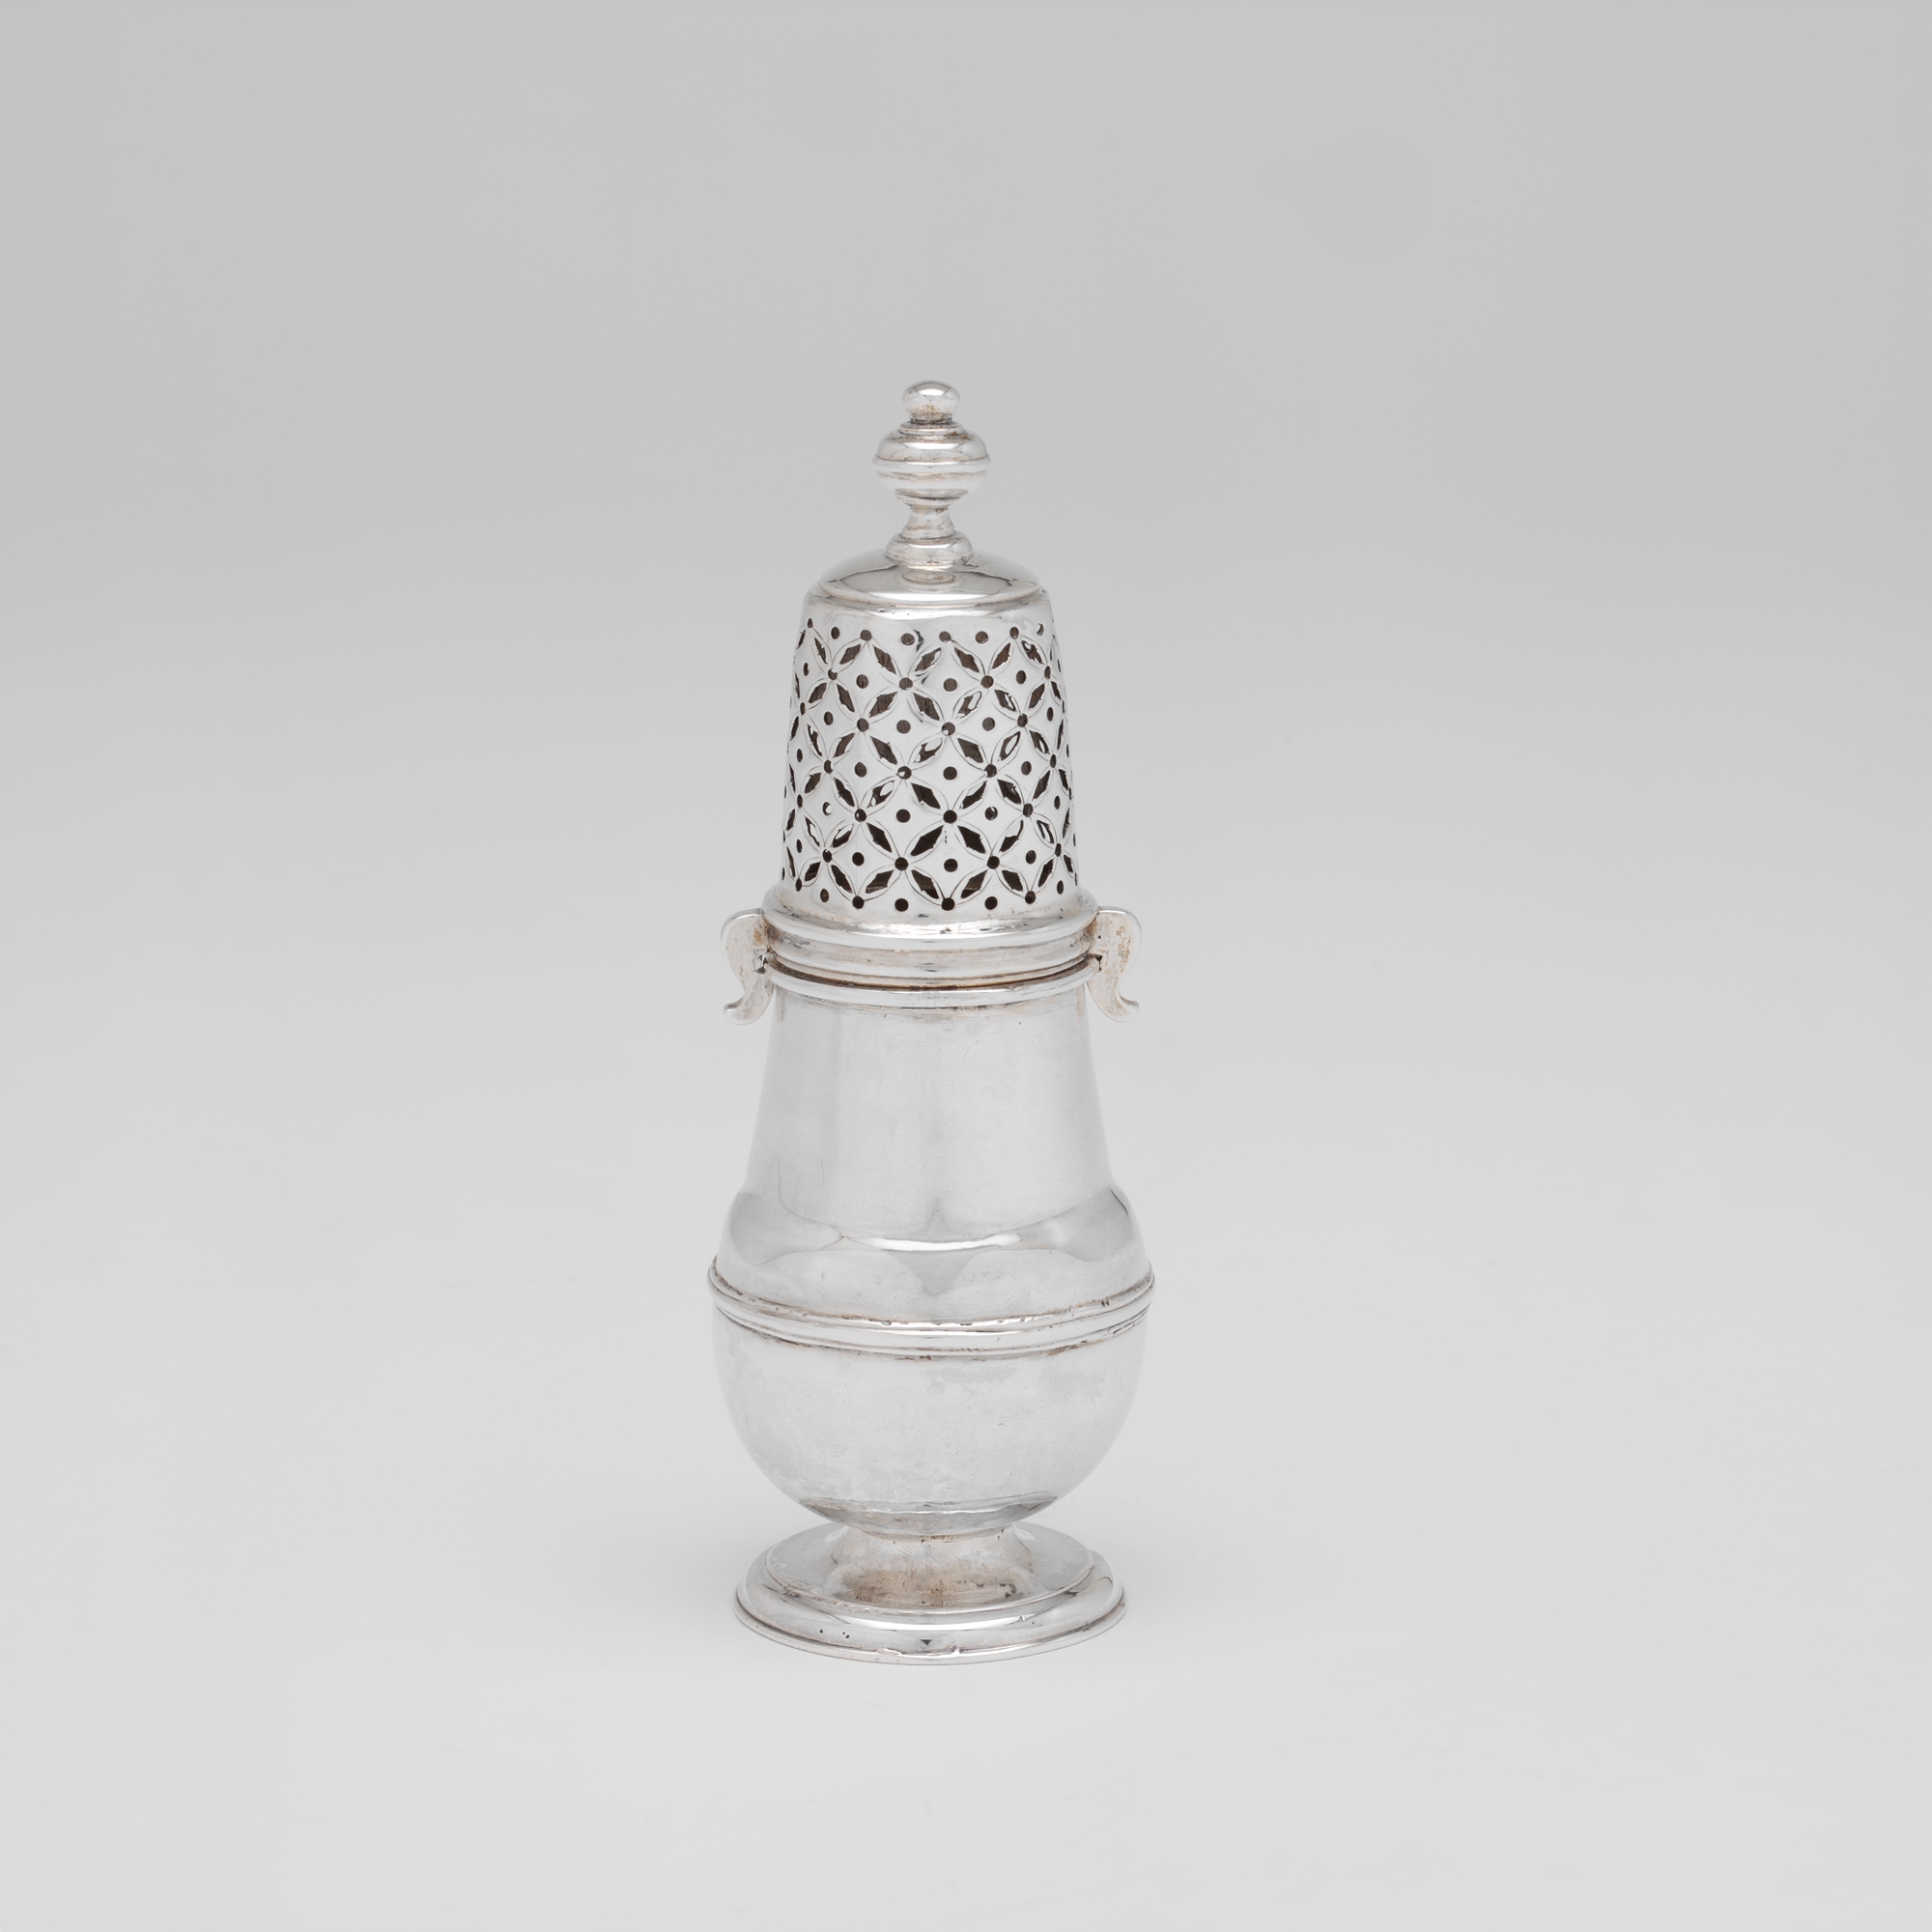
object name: caster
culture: american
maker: adrian bancker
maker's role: maker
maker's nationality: american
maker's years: 1703-1772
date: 1735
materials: silver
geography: united states